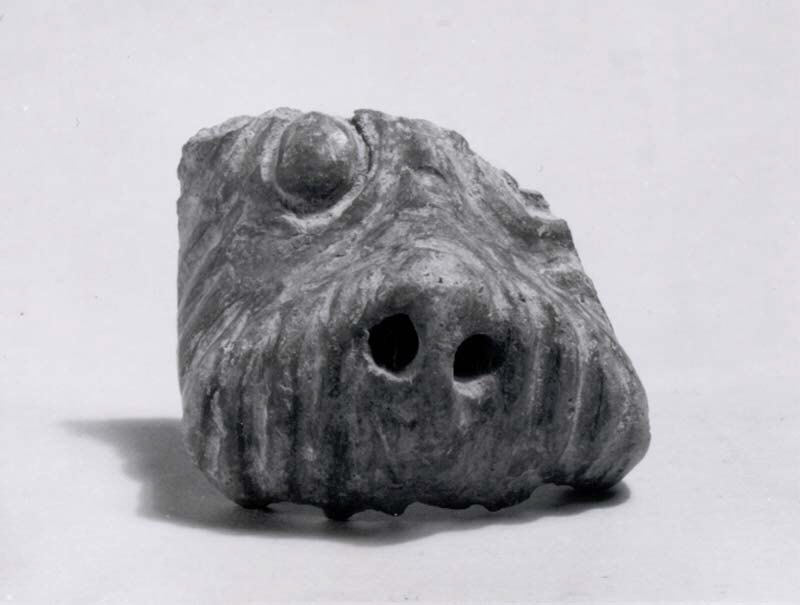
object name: sculpture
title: Lion figurine fragment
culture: iranian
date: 900-801 BCE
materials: ceramic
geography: iran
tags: lions